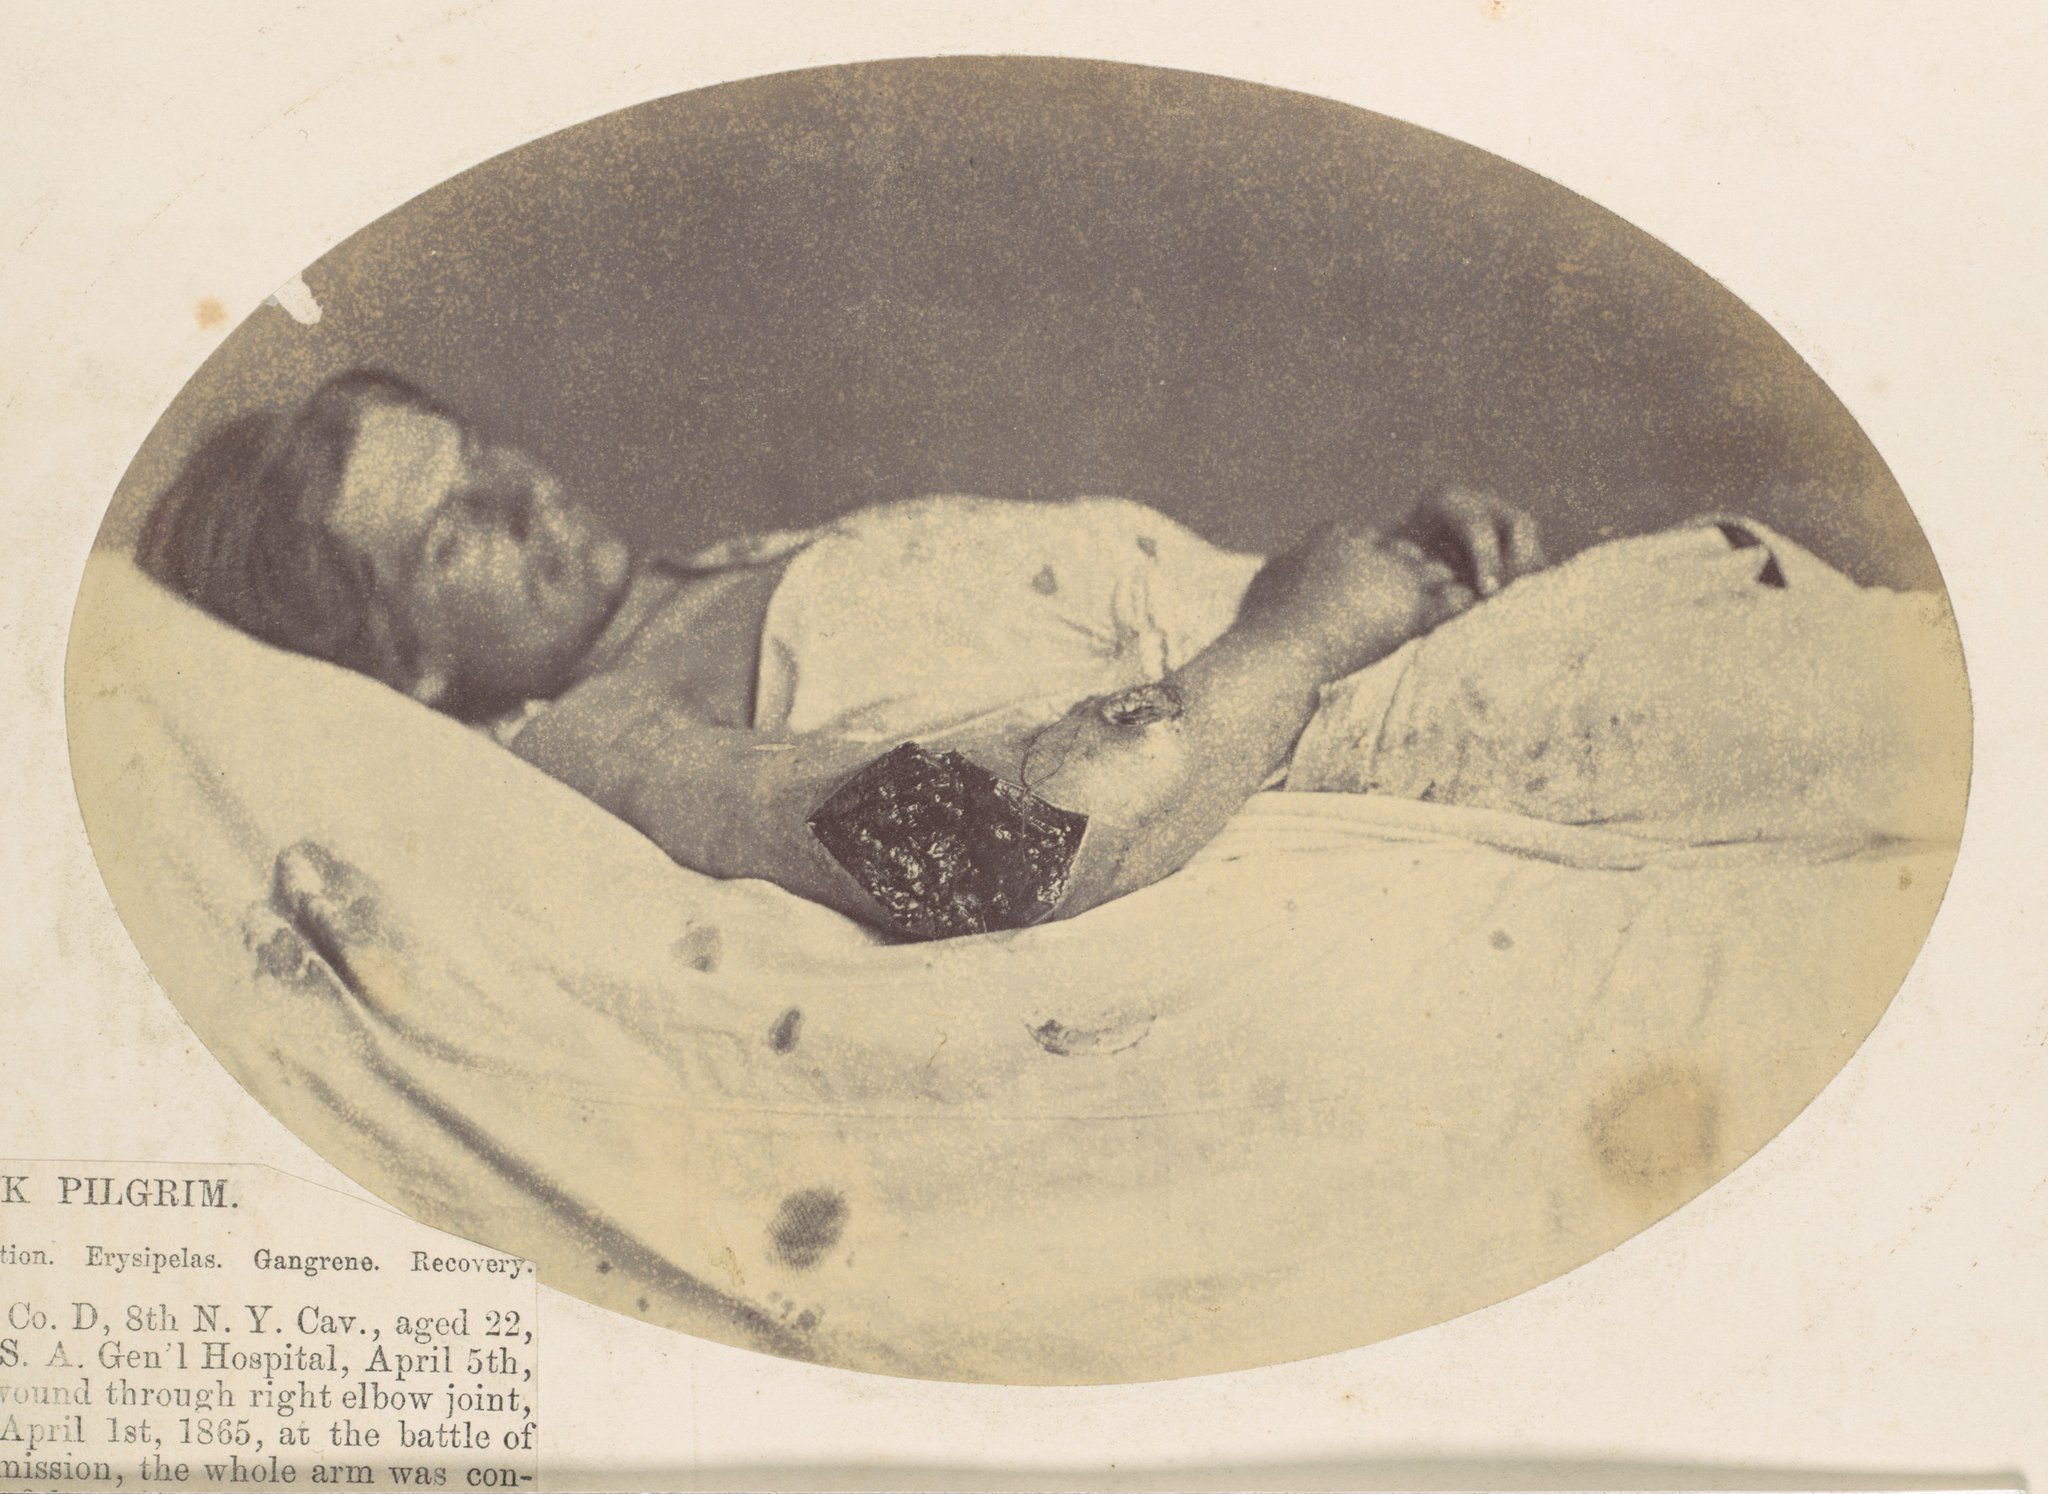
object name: photograph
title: Frederick Pilgrim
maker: reed brockway bontecou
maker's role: artist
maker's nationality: american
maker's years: 1824-1907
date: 1865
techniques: albumen silver print, glass negative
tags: soldiers,american civil war,men